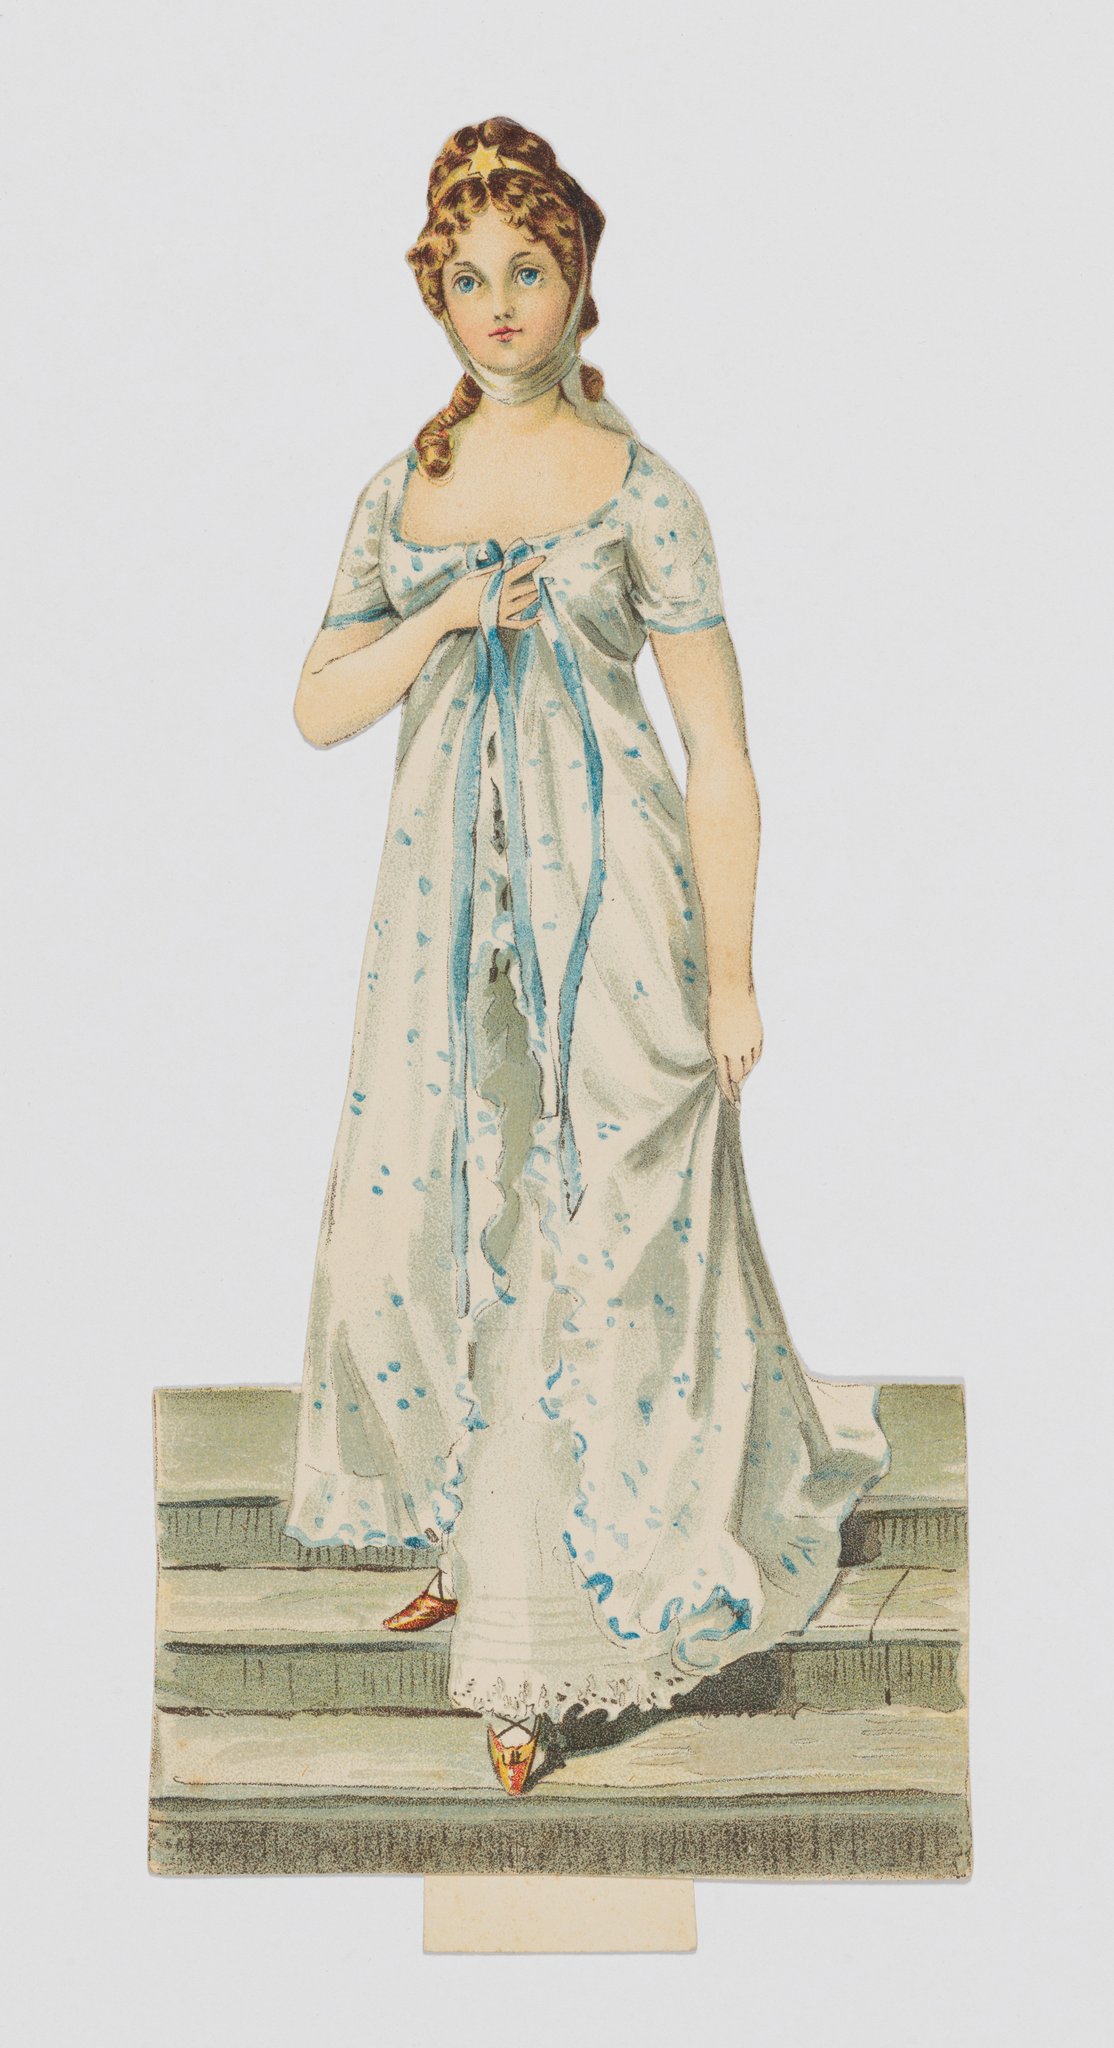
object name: paper doll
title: Queen Louise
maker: elizabeth s. tucker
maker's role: artist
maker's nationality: american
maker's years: 1850-1930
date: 1895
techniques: lithograph